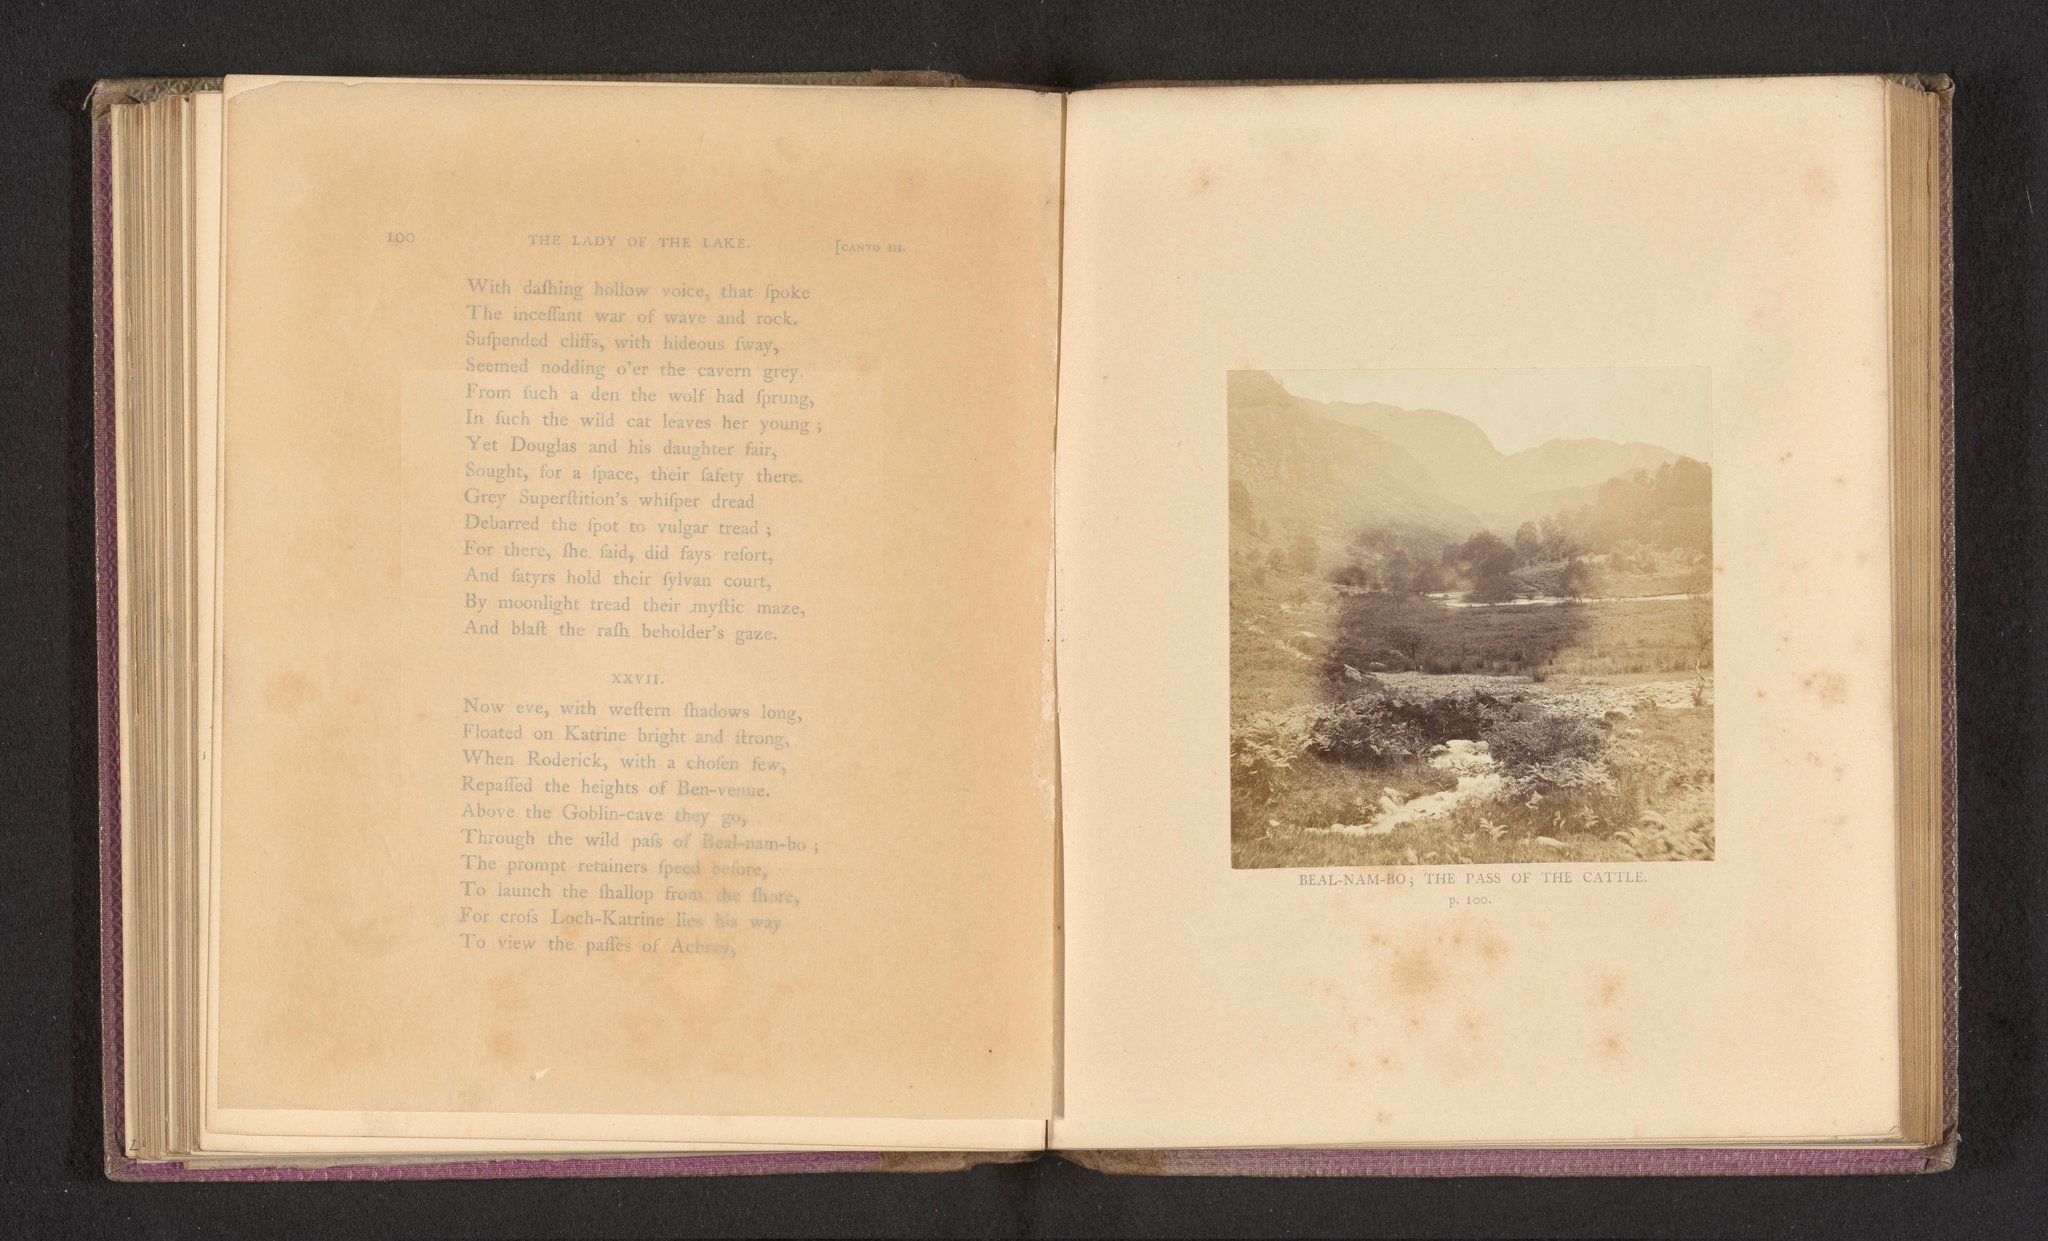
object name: photograph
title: Gezicht op Bealach na Bà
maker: thomas ogle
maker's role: fotograaf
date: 1853-1863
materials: photographic support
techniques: albumen print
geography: bealach na bà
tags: mountains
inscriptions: number: ‘P. 100.’